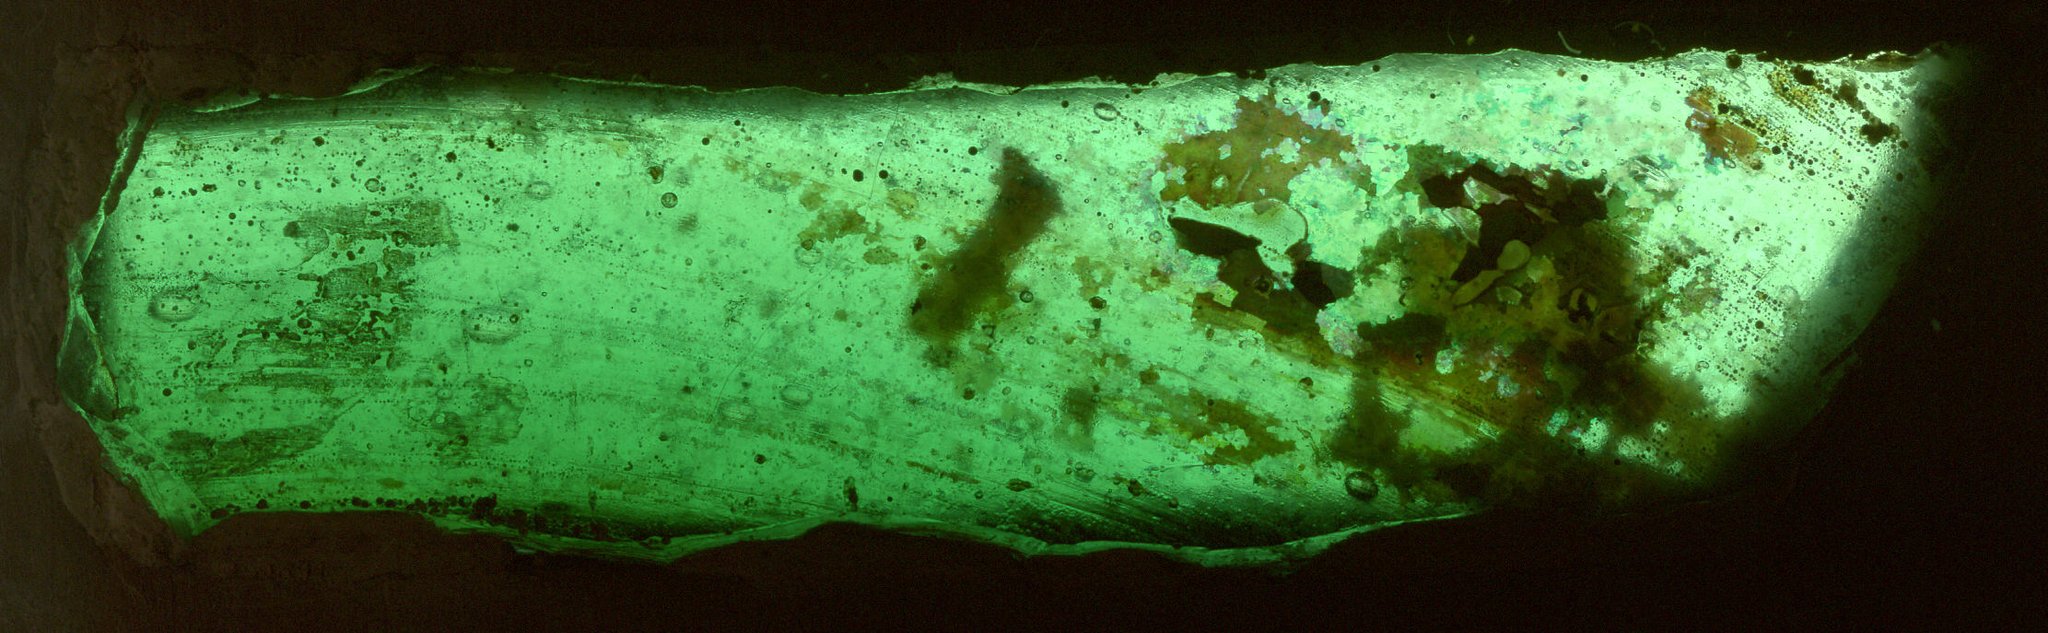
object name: fragment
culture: crusader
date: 1201-1300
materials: glass